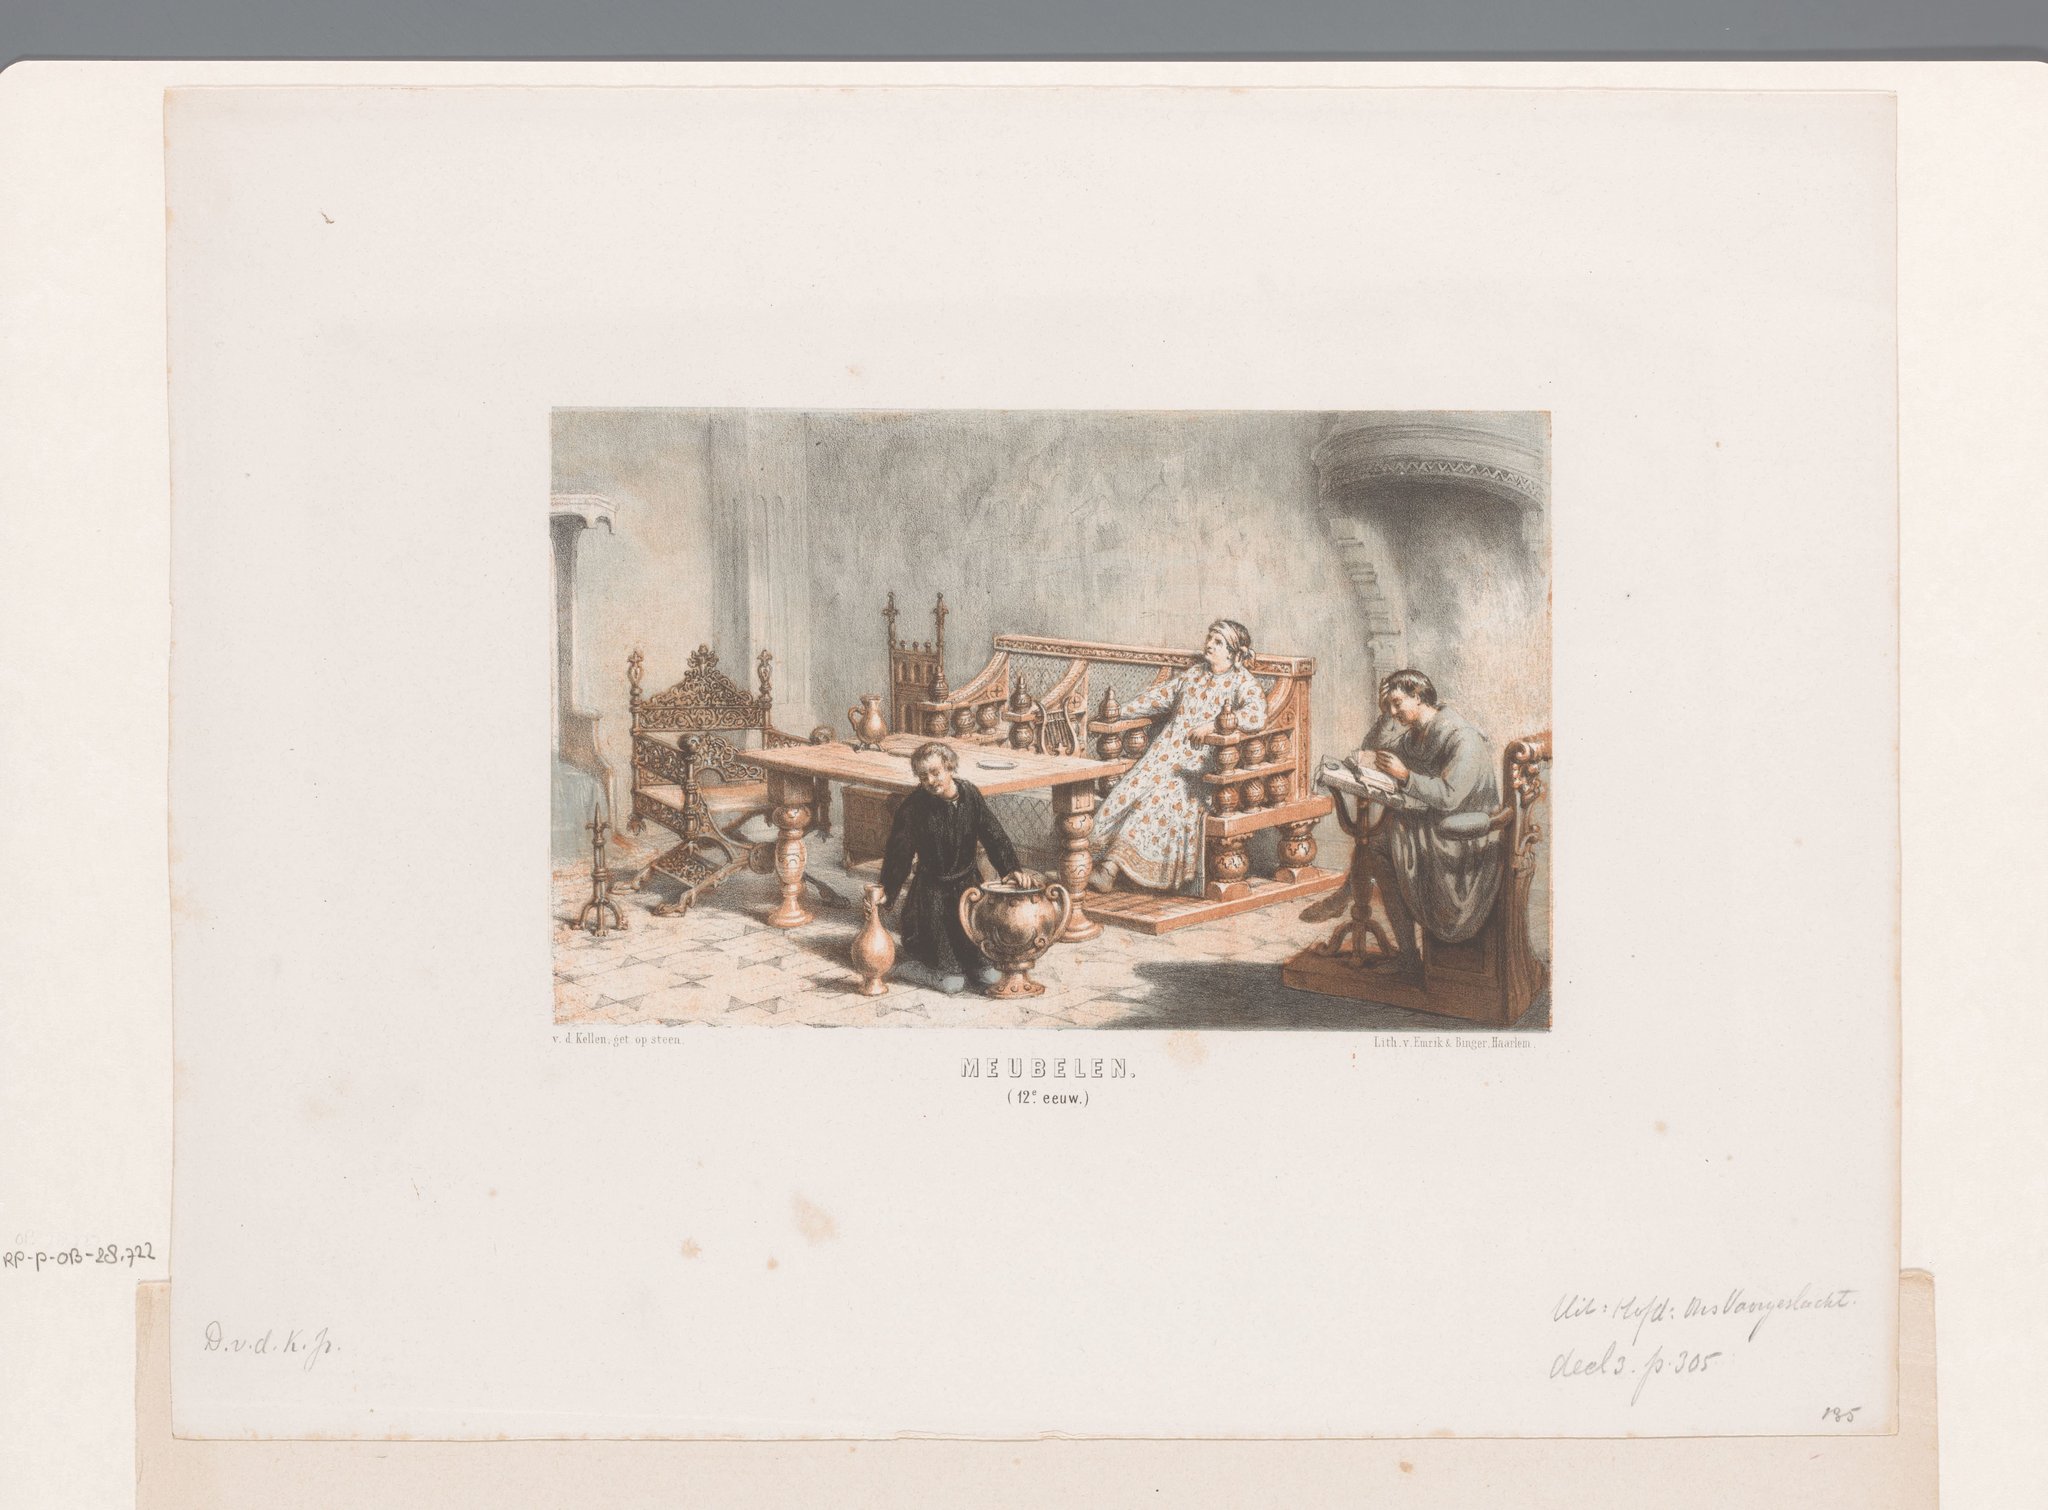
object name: historical object representation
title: Meubelen. (12e eeuw)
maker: david van der kellen (1827-1895)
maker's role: draughtsman, print maker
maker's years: 1827-1895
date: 1857-1864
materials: paper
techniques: tone lithography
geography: haarlem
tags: furniture and household effects, netherlands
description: Illustratie voor: W.J. Hofdijk, Ons voorgeslacht in zijn dagelyksch leven geschilderd, Kruseman, Haarlem 1859-1864, dl. 3, p. 305.